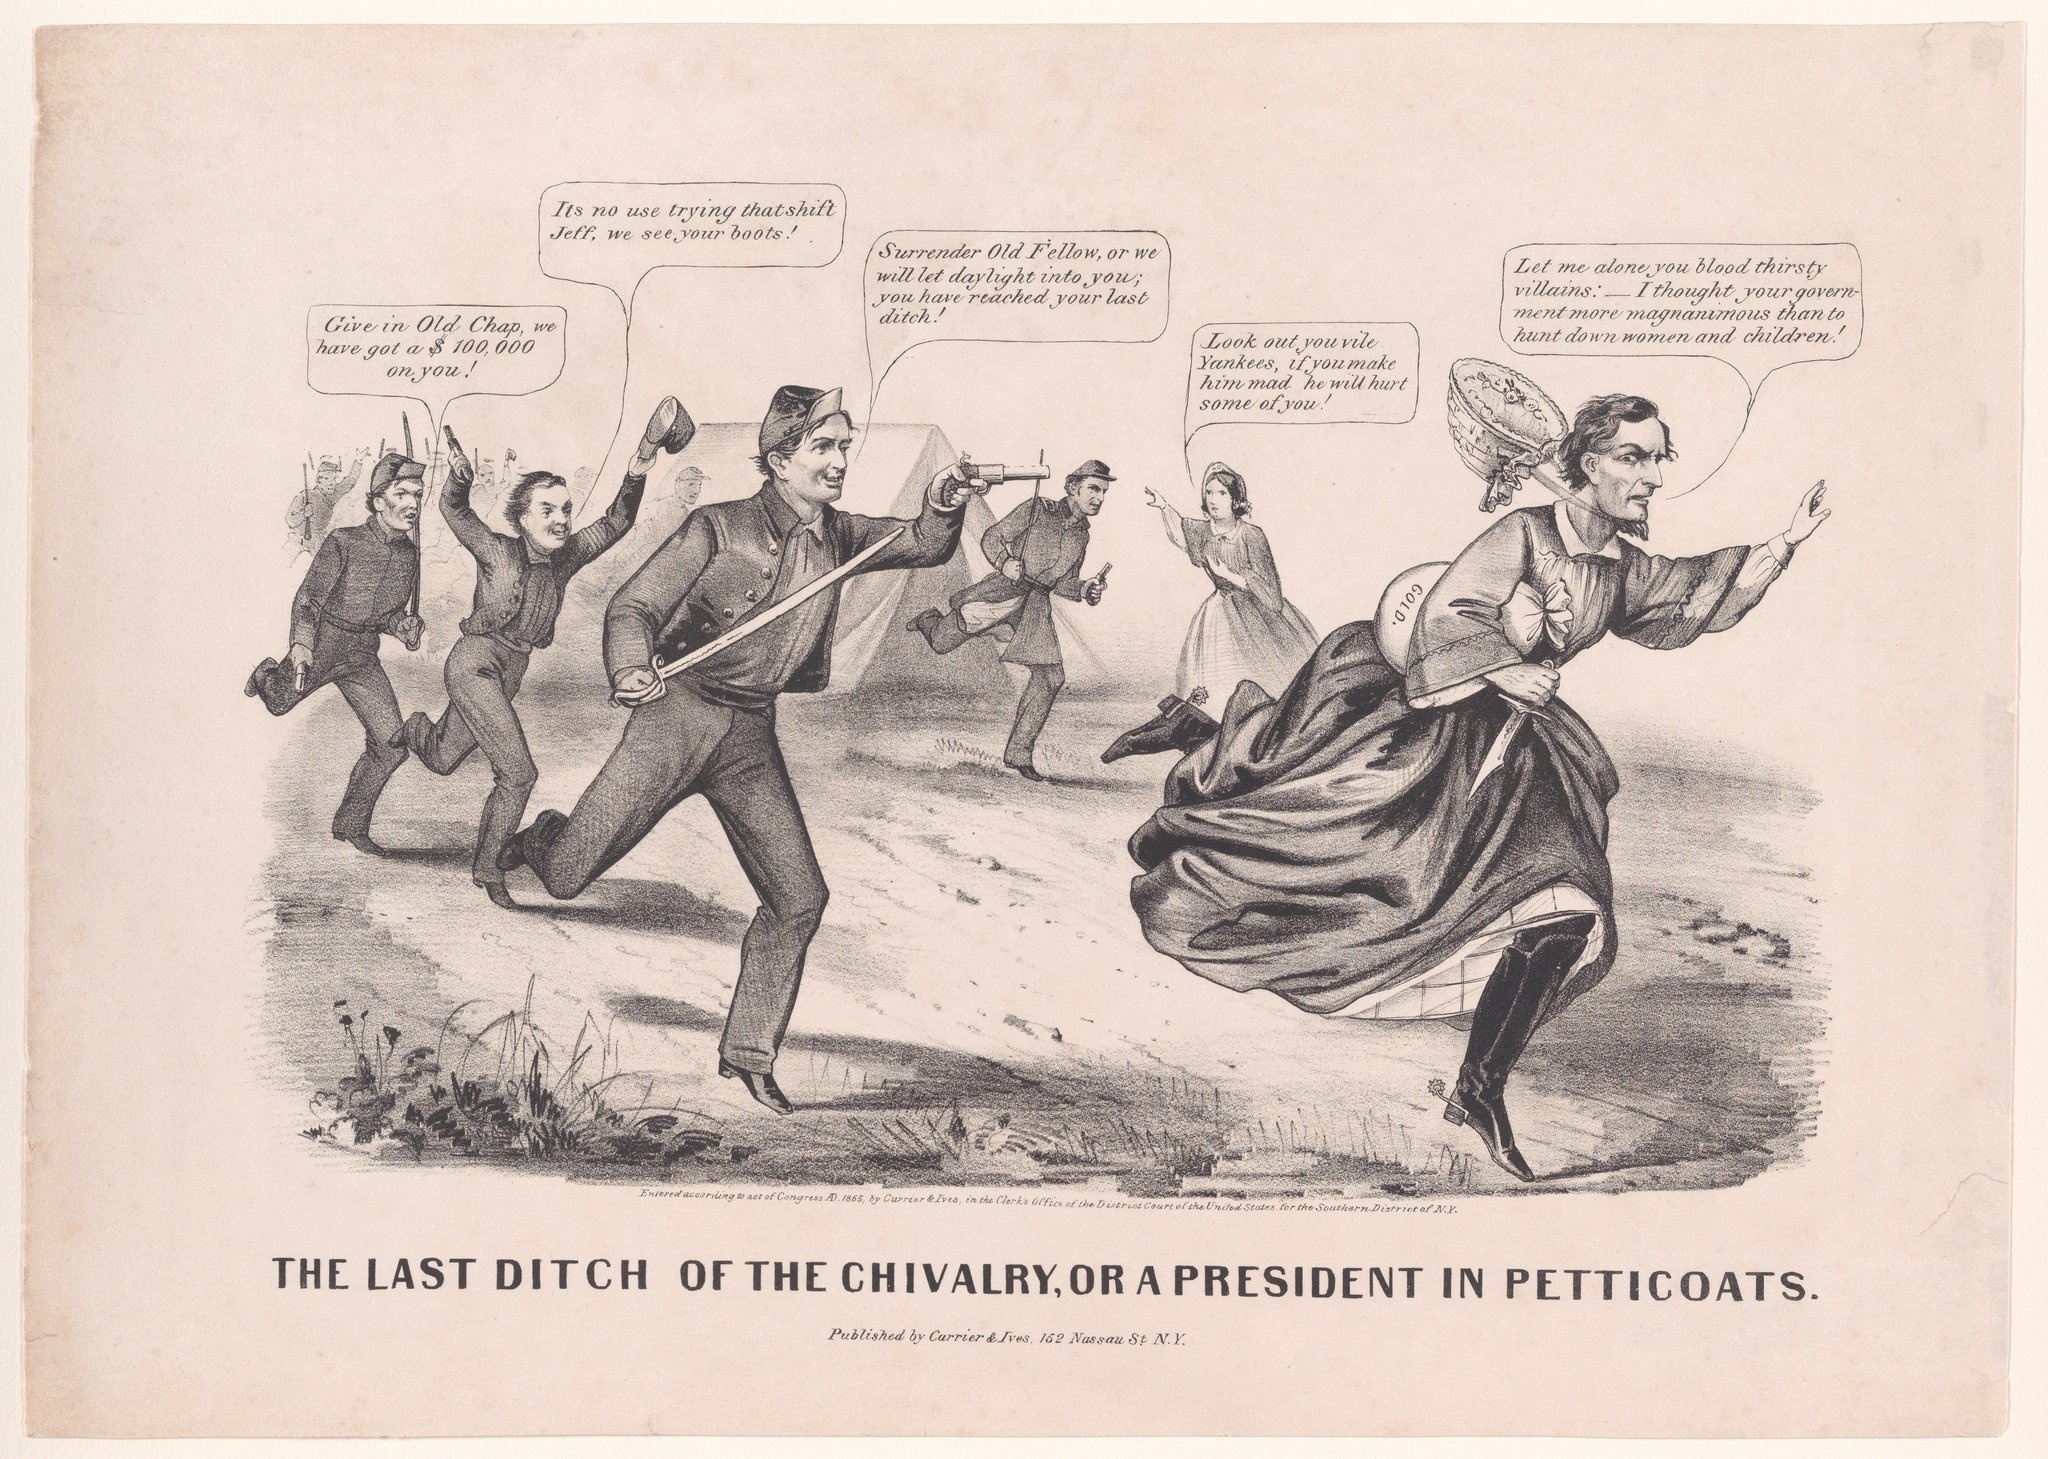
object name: print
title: The Last Ditch of the Chivalry, or a President in Petticoats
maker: currier & ives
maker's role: publisher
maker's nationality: american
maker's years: 1857-1907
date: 1865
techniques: lithograph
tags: satire,soldiers,american civil war,men